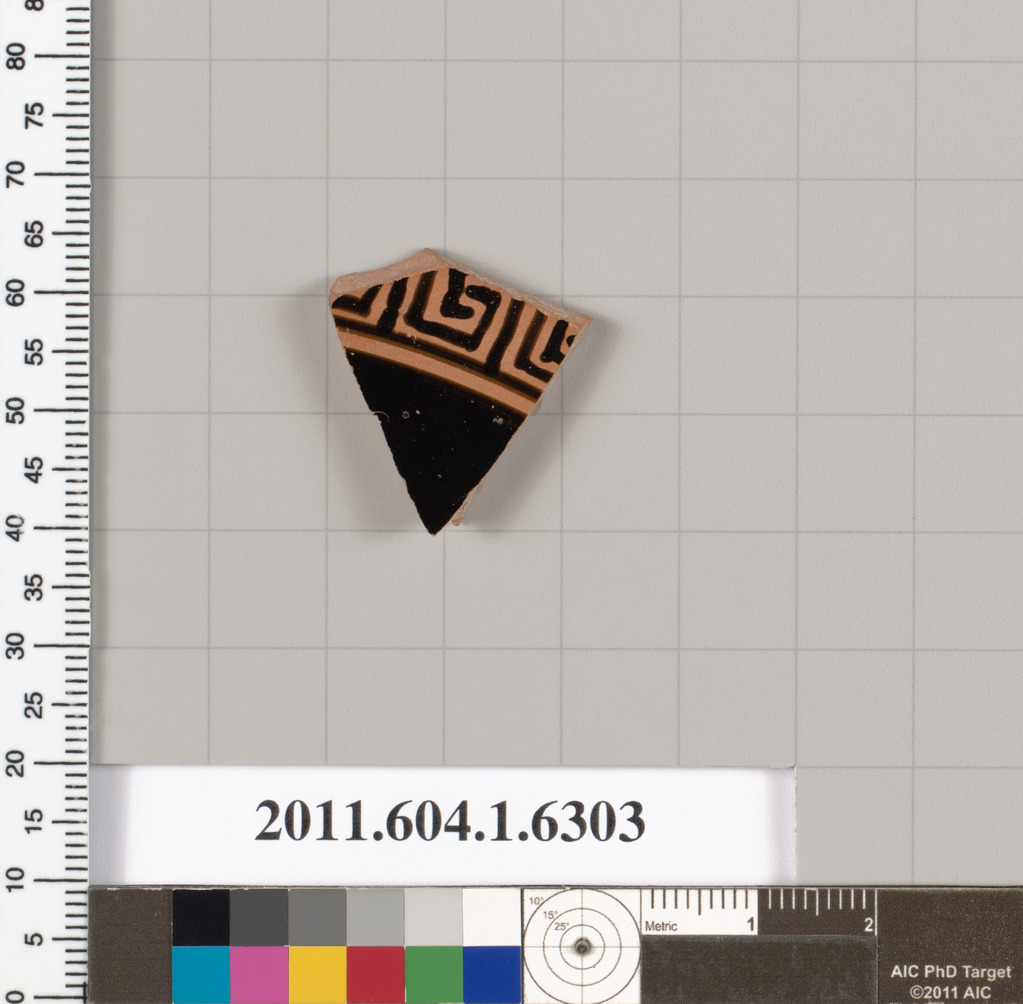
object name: kylix fragment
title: Terracotta fragment of a kylix (drinking cup)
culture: greek, attic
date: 500-480 BCE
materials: terracotta